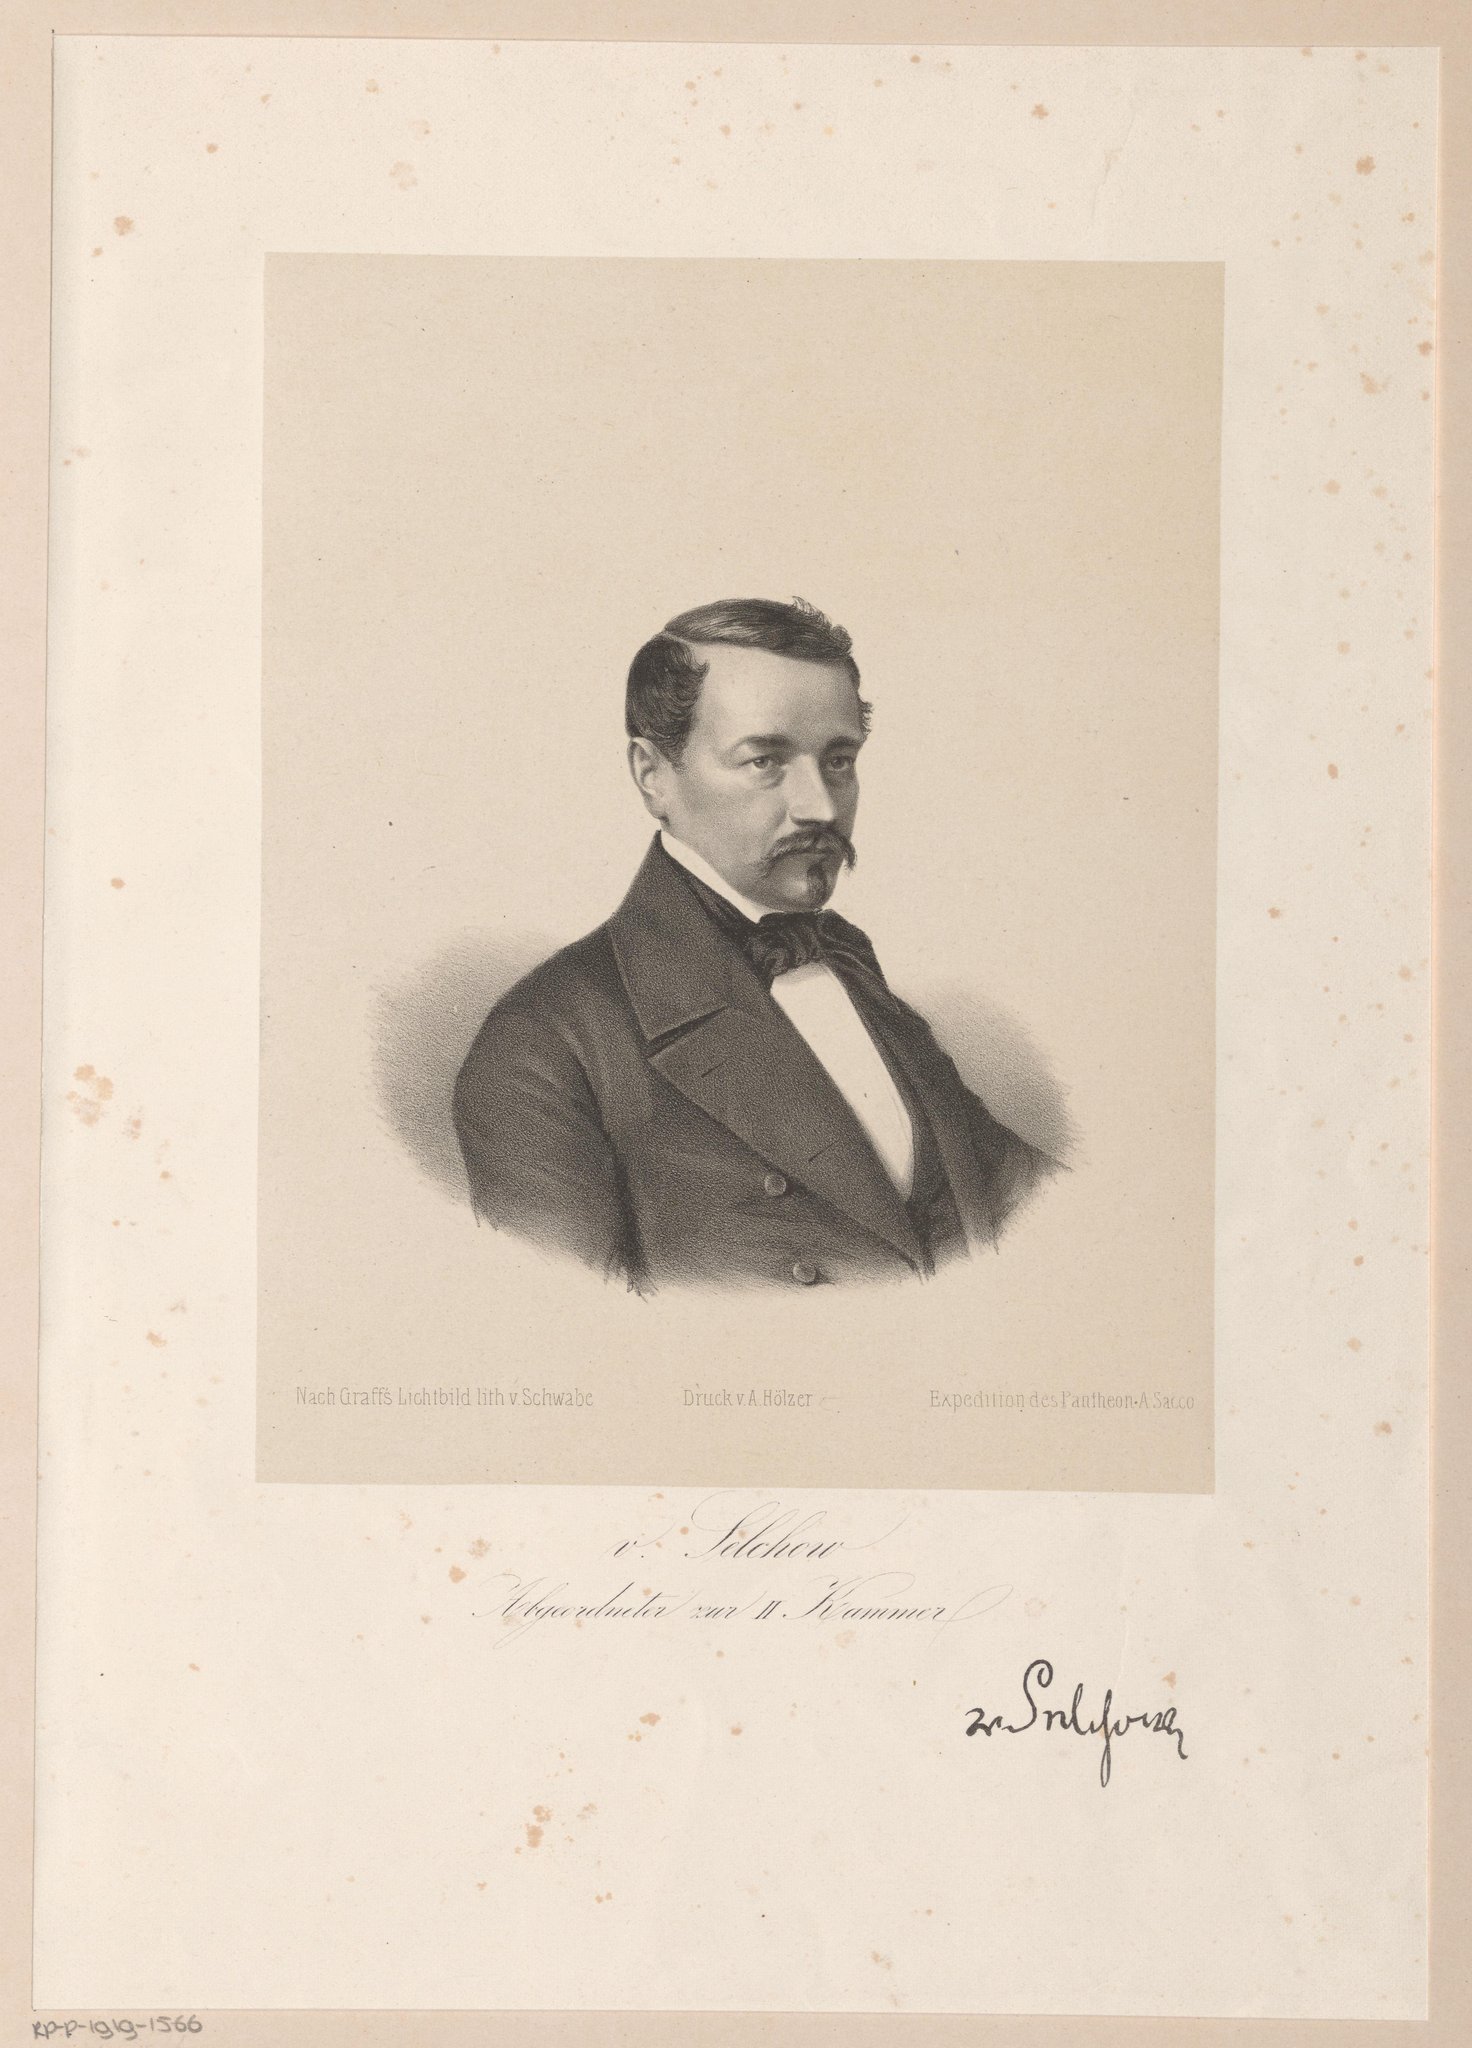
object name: print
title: v. Selchow, Abgeordneter zur II Kammer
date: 1830-1899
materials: paper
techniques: lithograph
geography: berlin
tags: politician, historical persons, politician, e.g. party leader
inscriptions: collector's mark: Lugt 2228